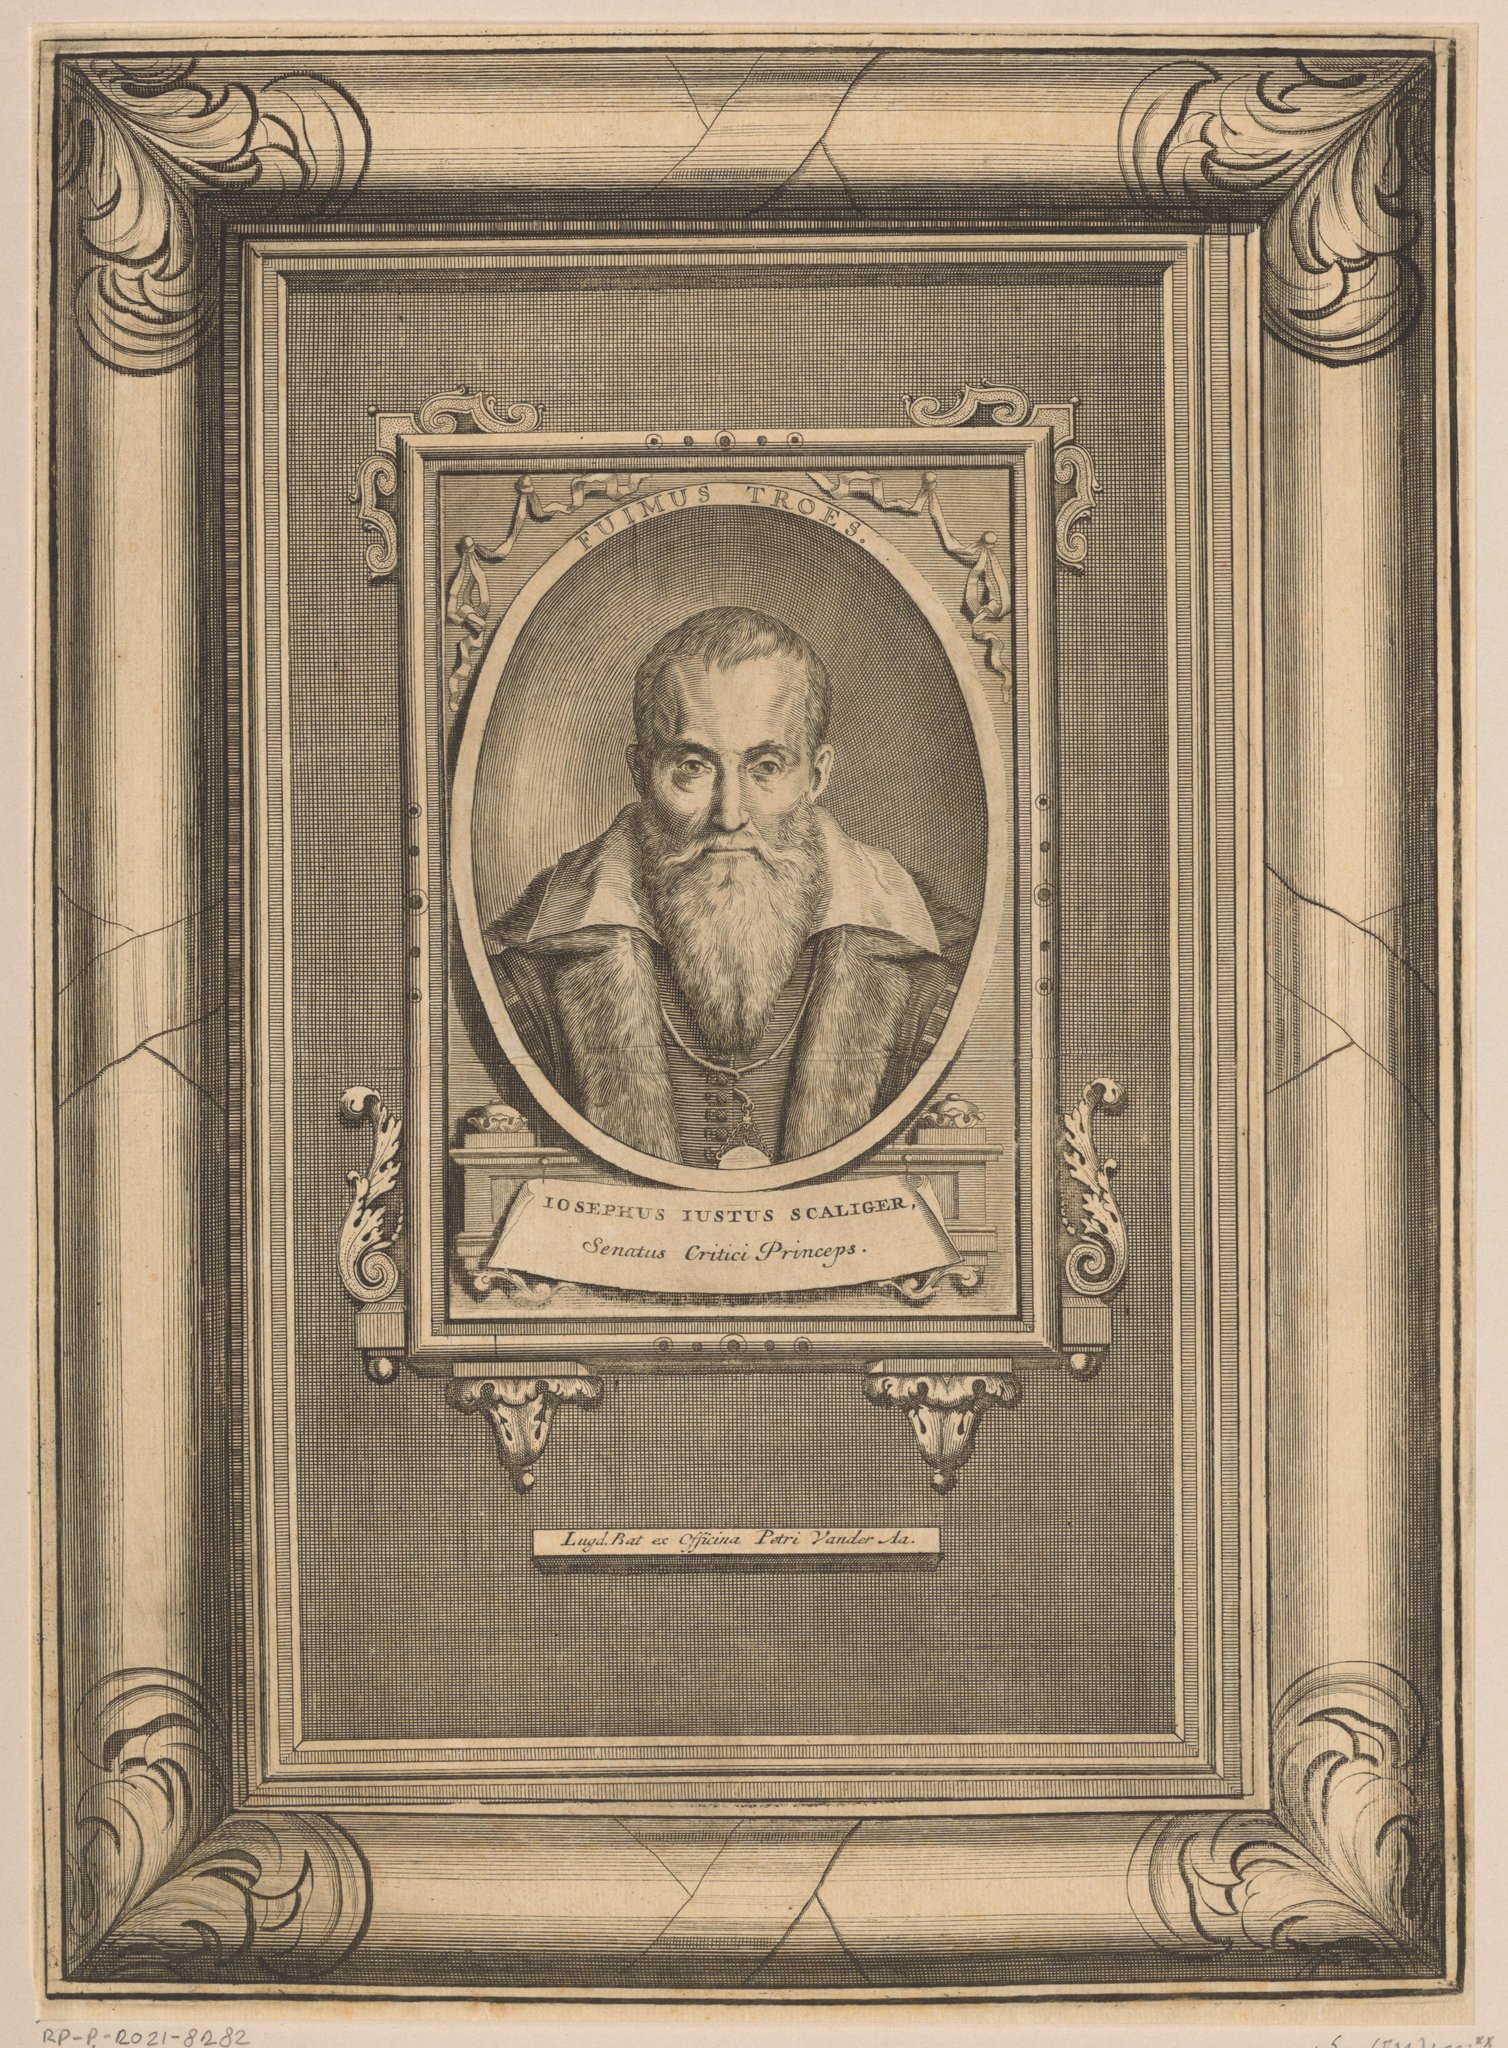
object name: print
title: Portret van Josephus Scaliger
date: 1609-1720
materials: paper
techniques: engraving, etching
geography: leiden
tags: historical persons, professor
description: Prent zonder tweede omlijsting gebruikt in: Fundatoris, curatorum et professorum celeberrimorum, aliorumque illustrium virorum (...). Leiden: Pieter (I) van der Aa, [1720]. Eerdere staat van prent ook gebruikt in: Meursius, Joannes. Icones ad vivum delineatae et expressae. Leiden: Andries Clouck, 1609. Eerdere staat van prent ook gebruikt in andere publicaties, zie Van Someren.